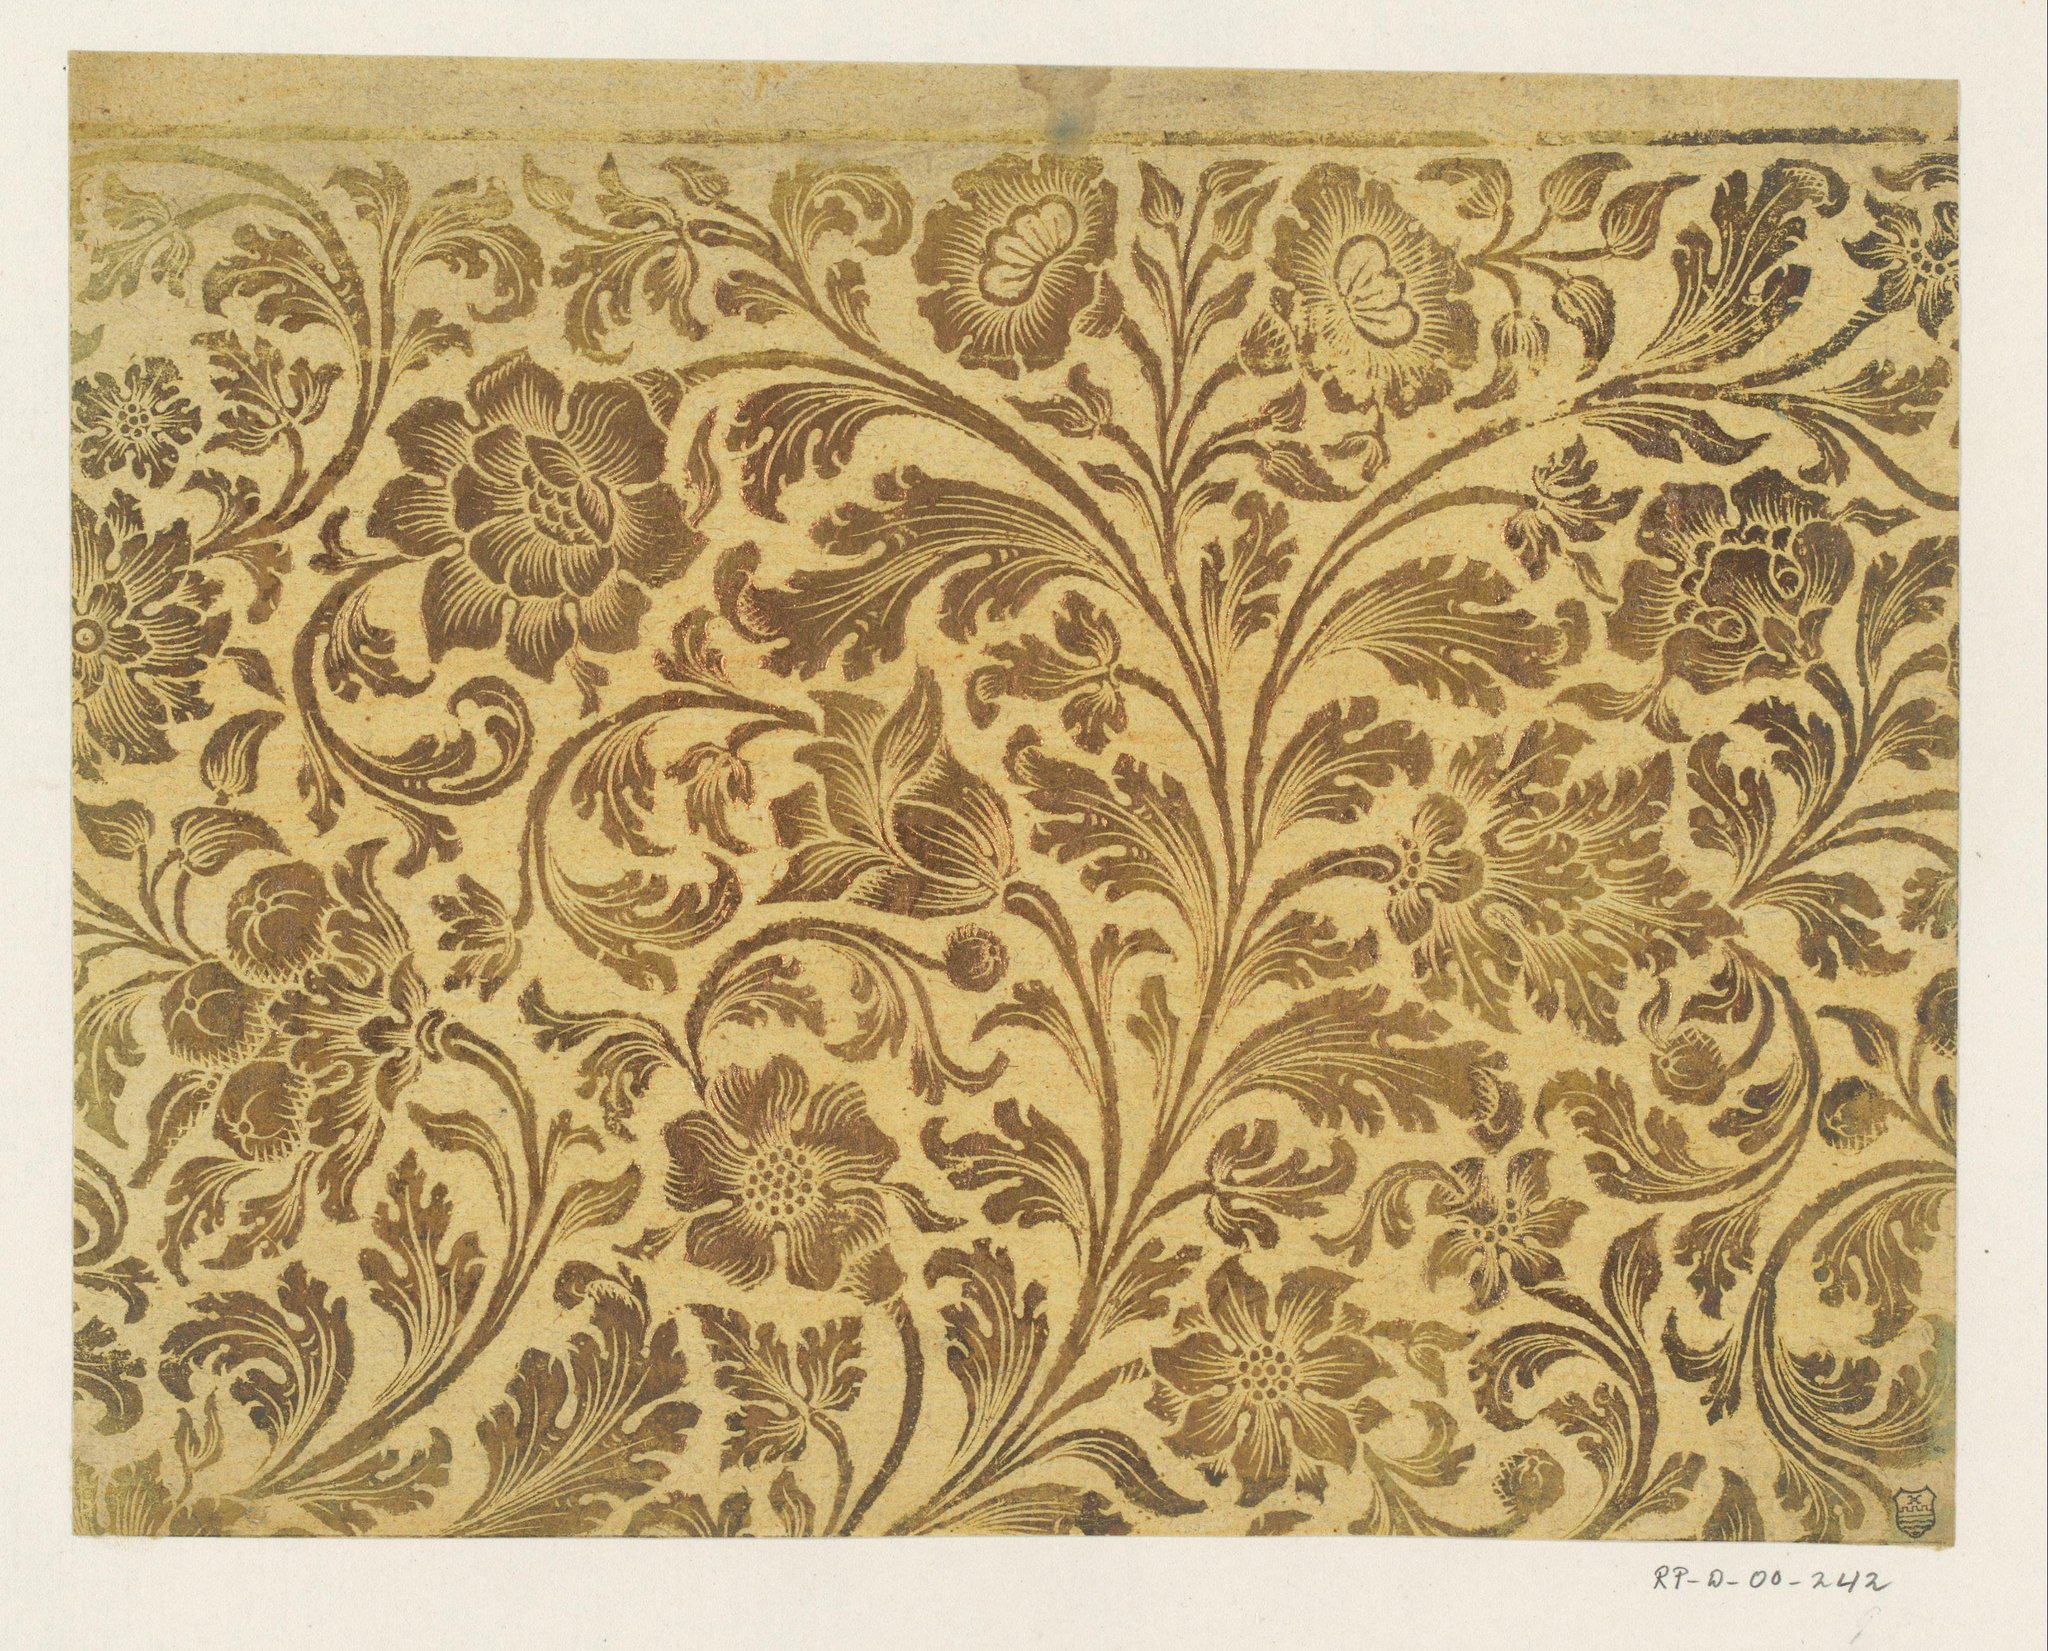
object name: brocade paper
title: Blad met gestileerde bloemen en bladeren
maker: Anonymous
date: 1750-1800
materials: gold leaf, paint, paper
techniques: relief print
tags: ornament derived from plant forms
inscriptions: collector's mark: Lugt 2760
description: Blad met gestileerde bloemen en bladeren.